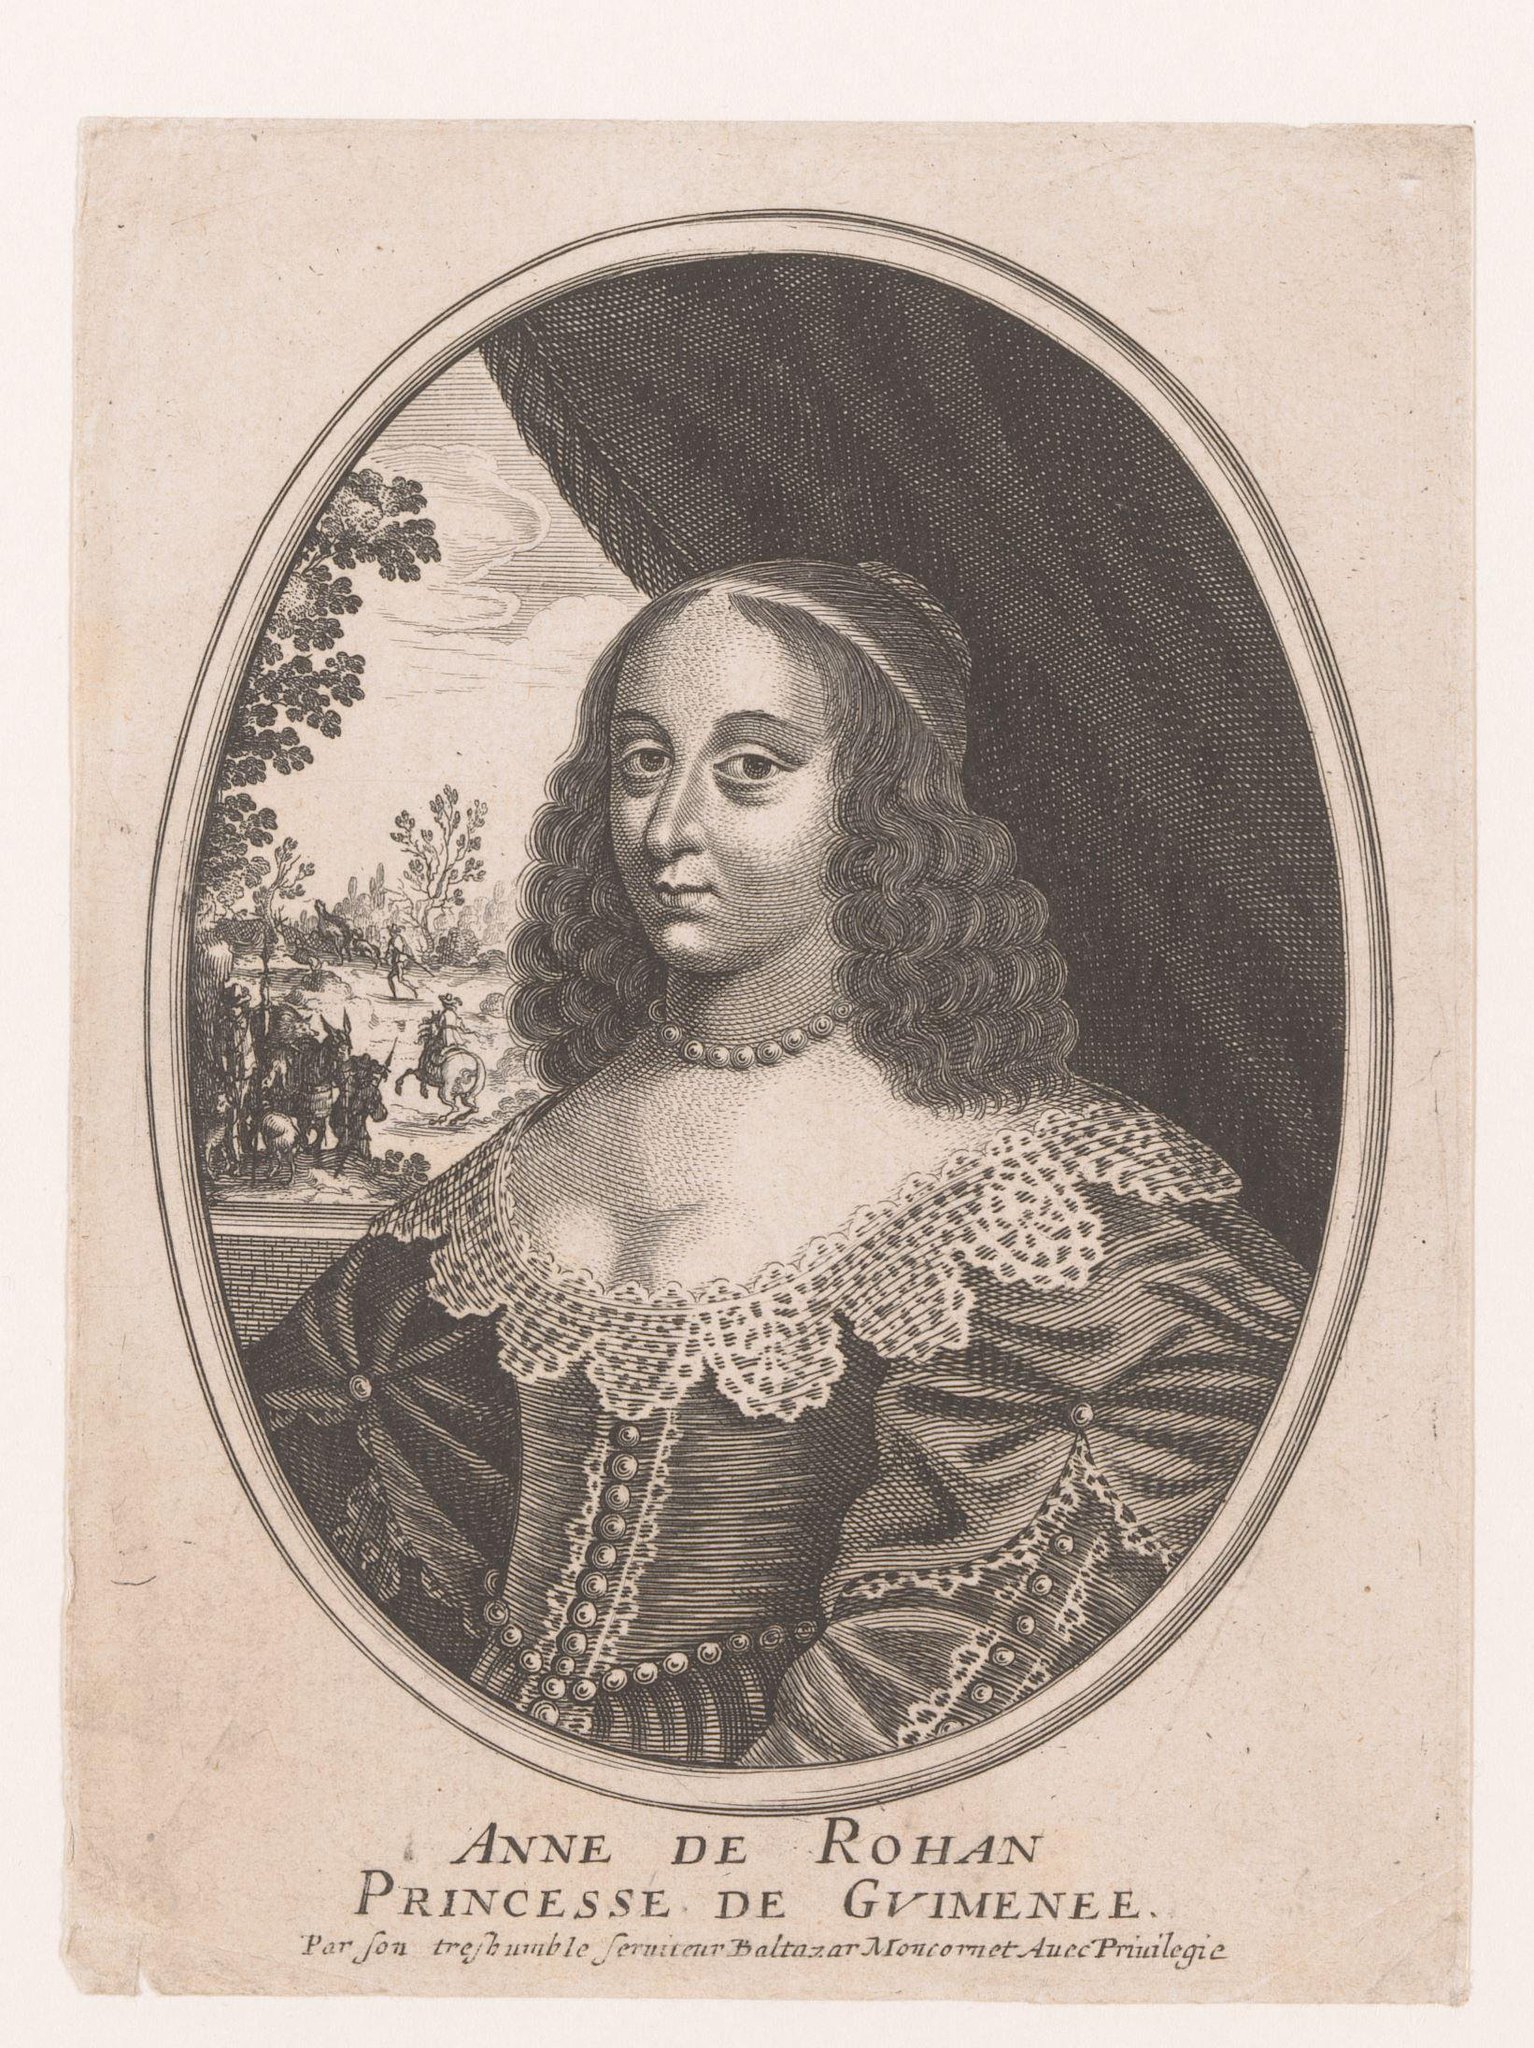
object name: print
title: Portret van Anne de Rohan-Guéméné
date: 1621-1668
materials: paper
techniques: engraving, etching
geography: france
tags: historical persons - bb - woman, armorial bearing, heraldry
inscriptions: collector's mark: Lugt 2228